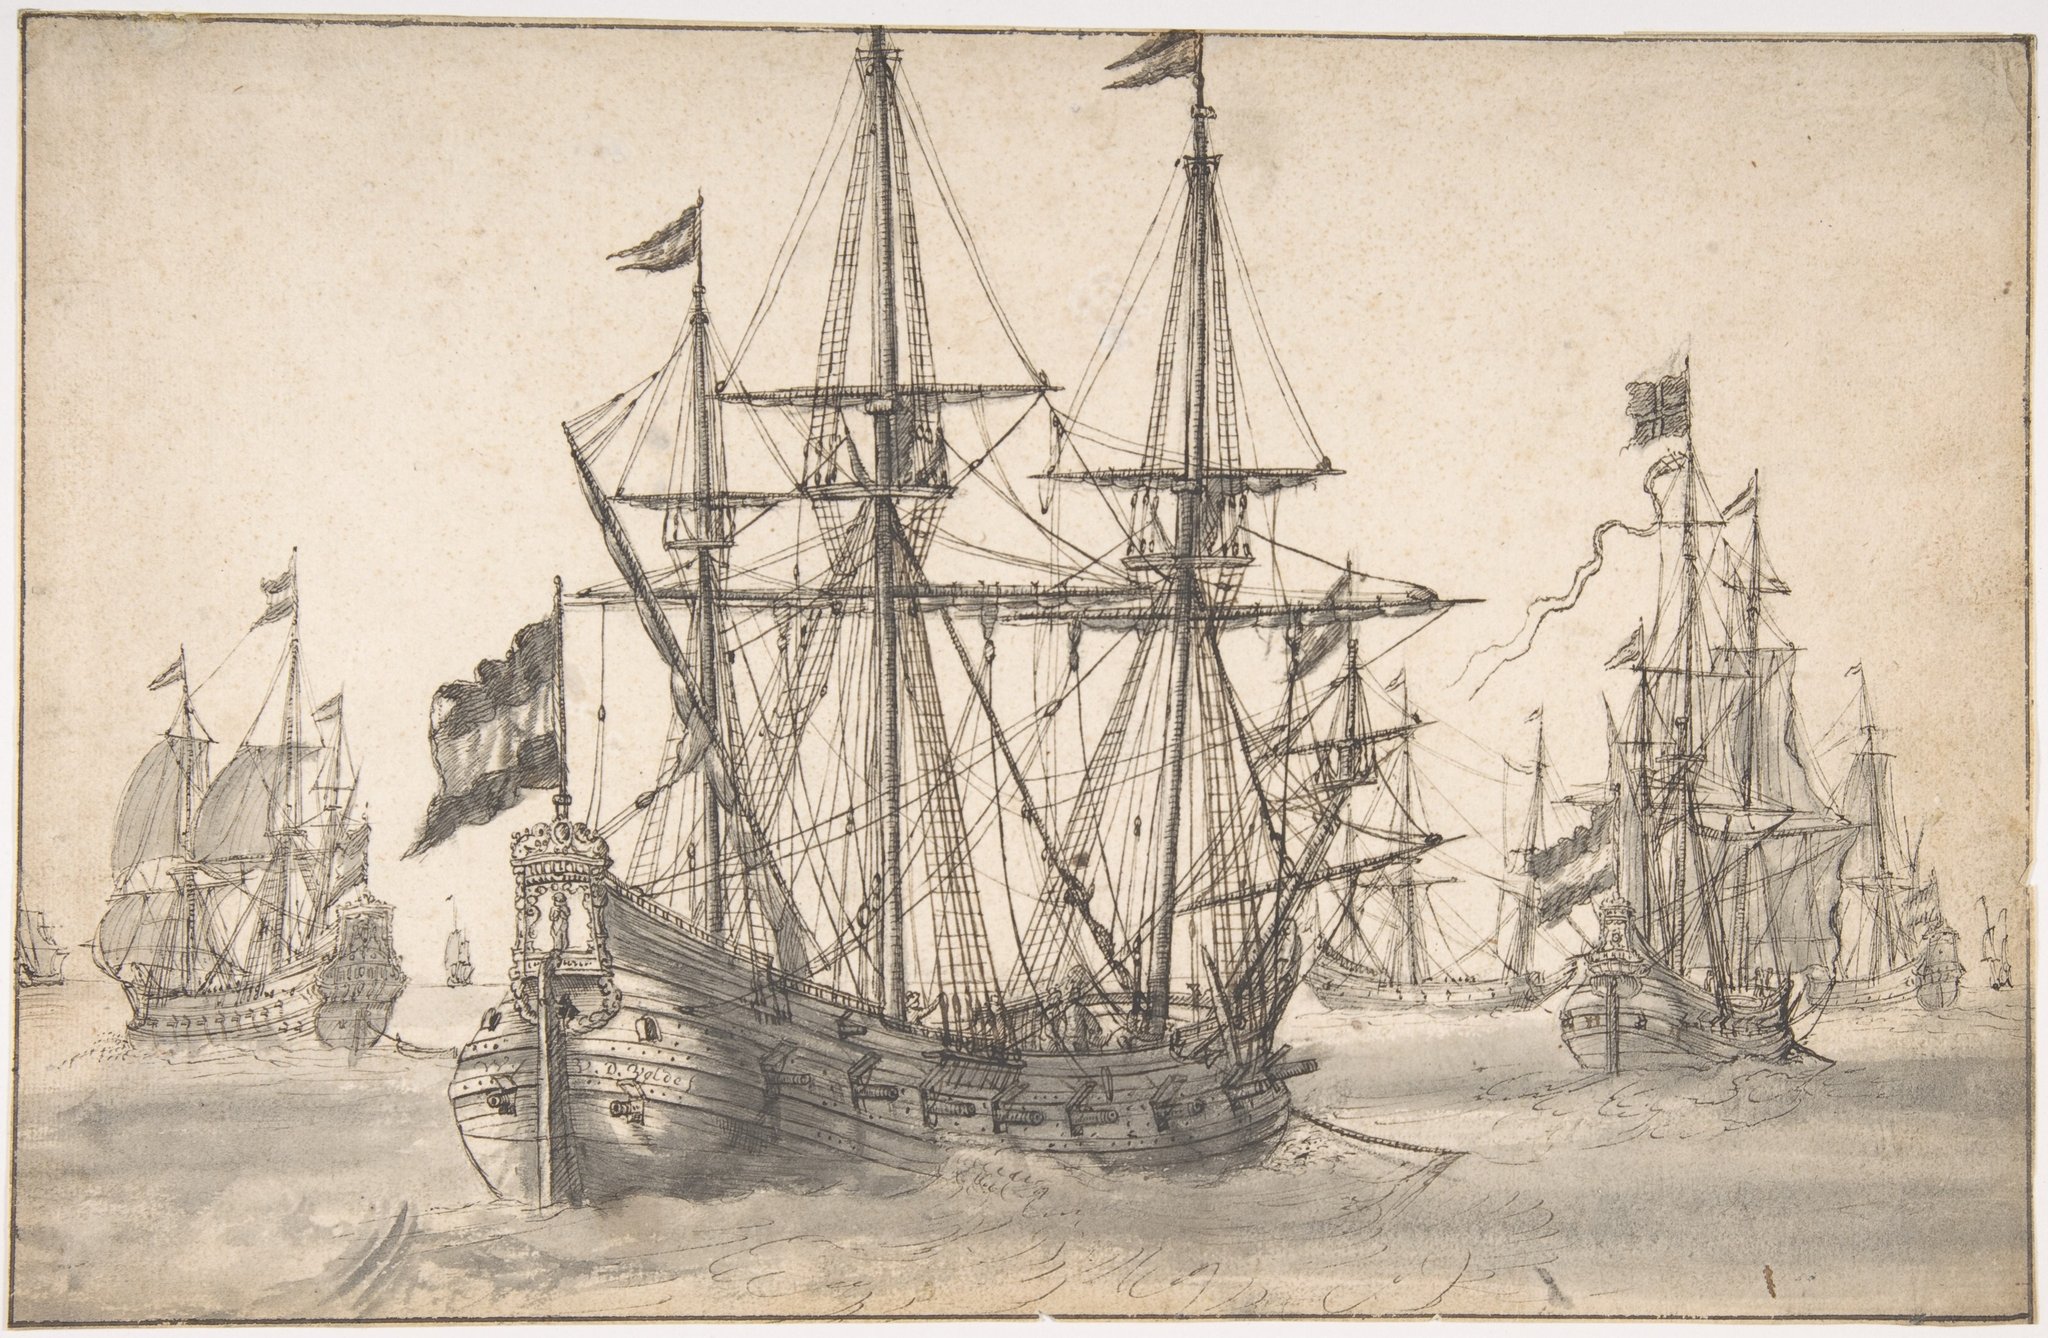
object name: drawing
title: Dutch Men of War at Anchor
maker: willem van de velde (i)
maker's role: artist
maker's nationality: dutch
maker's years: 1611-1693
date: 1601-1700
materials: chalk, ink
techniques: brush, pen, wash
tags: ships